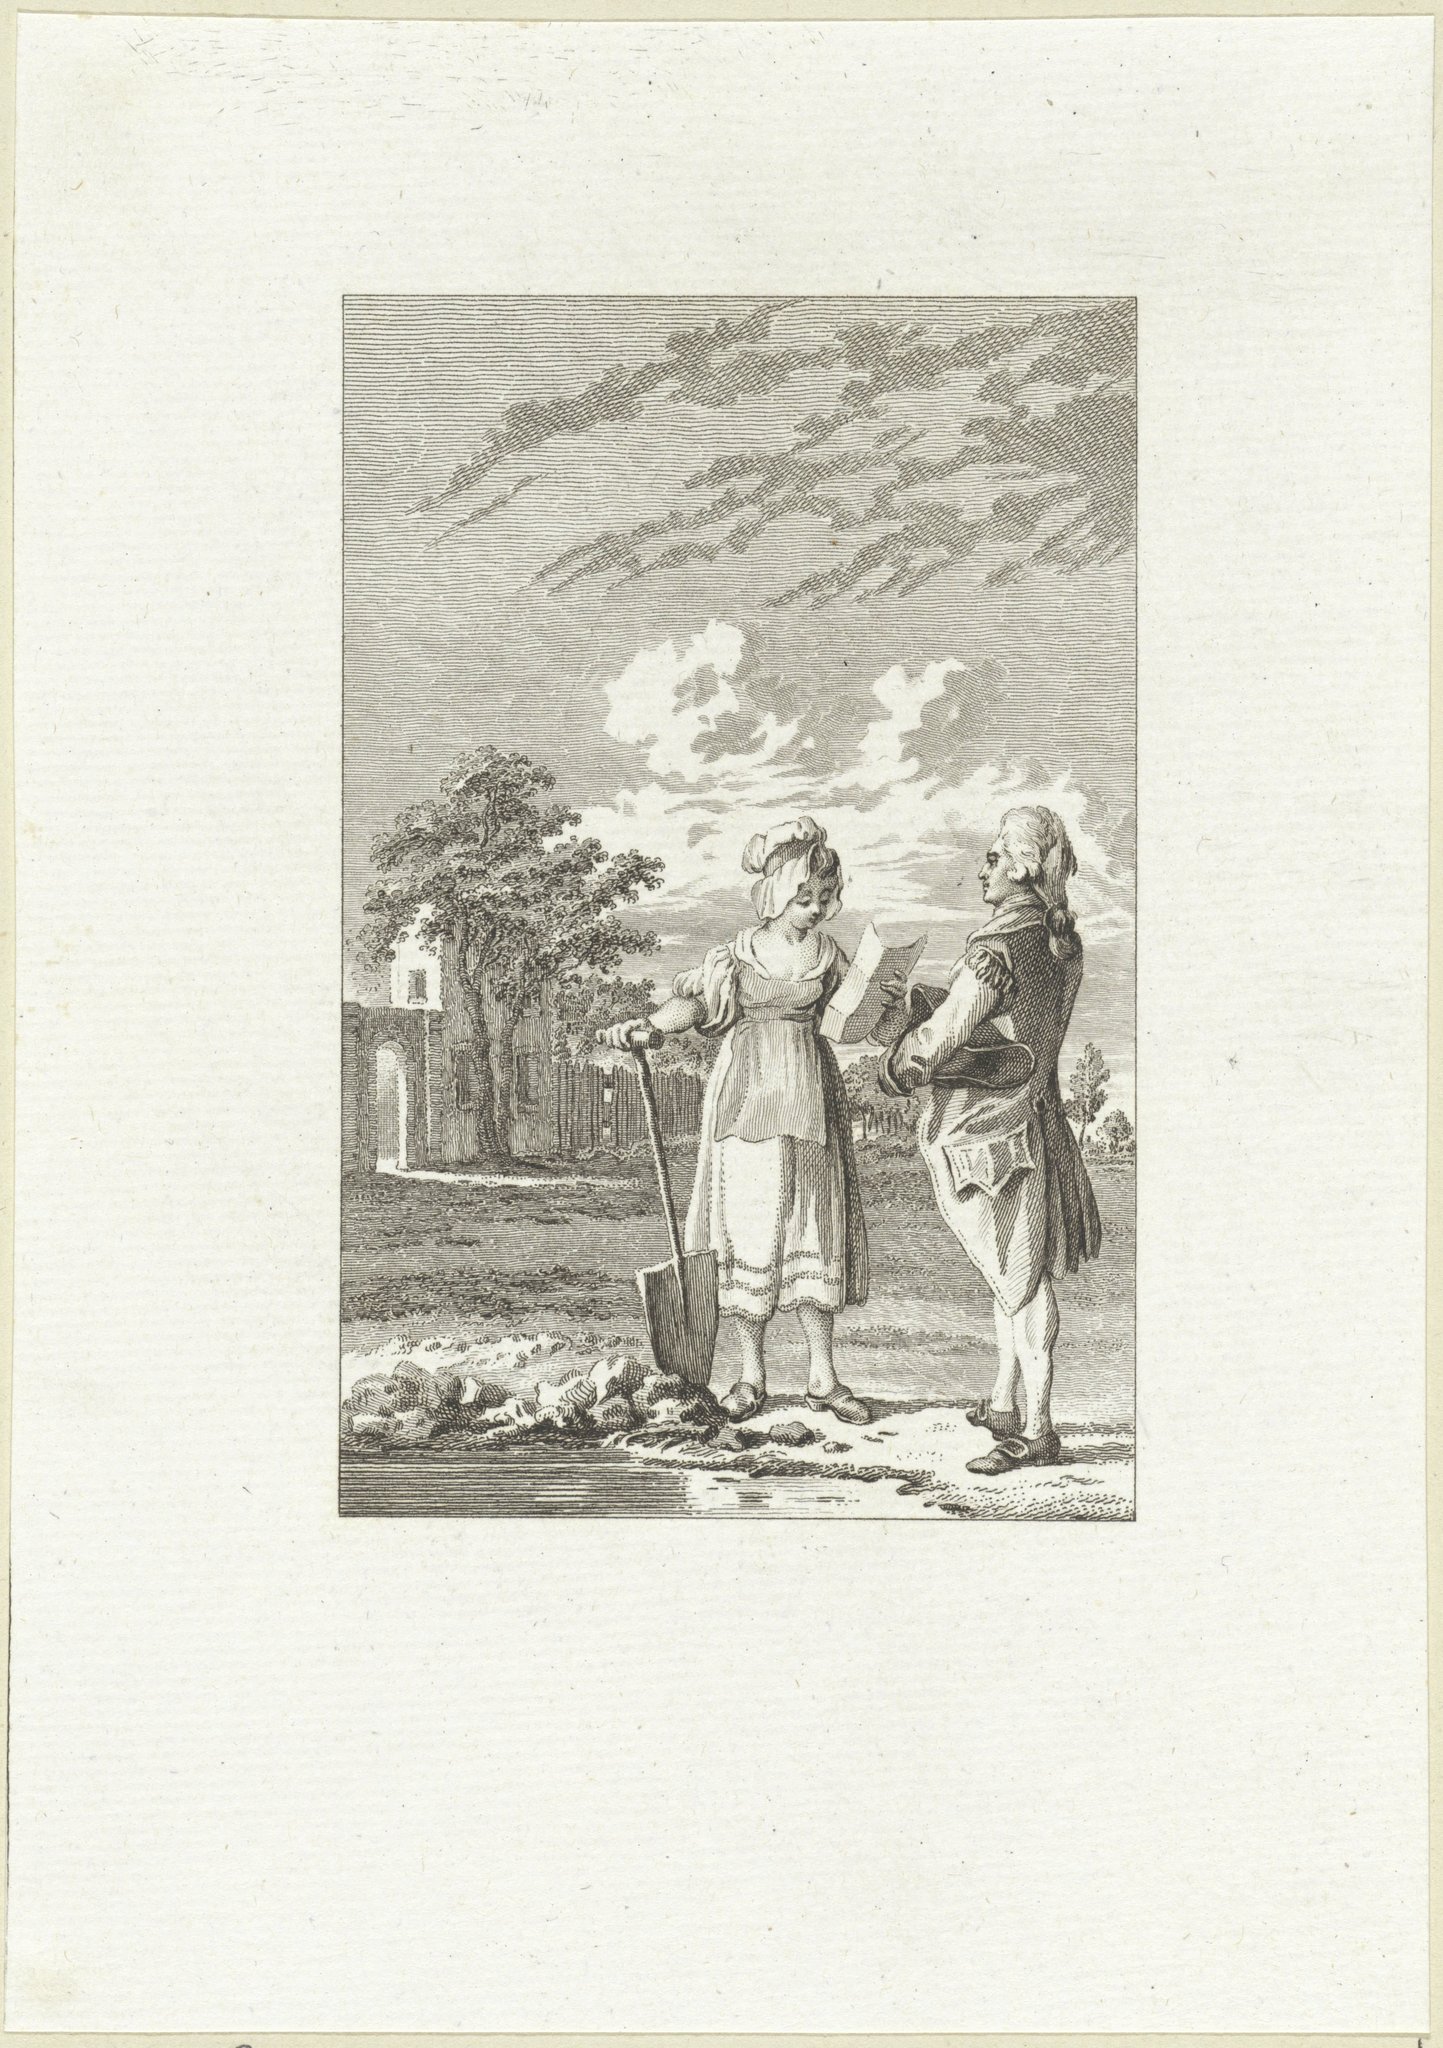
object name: print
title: Vrouw met een schep en een brief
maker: reinier vinkeles (i)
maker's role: draughtsman, print maker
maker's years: 1741-1816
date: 1789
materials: paper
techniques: engraving, etching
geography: amsterdam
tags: reading, landscapes, agricultural implements: spade, letter, envelope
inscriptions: collector's mark: Lugt 240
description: Proefdruk van een prent die ook gebruikt is als illustratie bij het verhaal 'Pauline en Suzette' voor: Baculard d'Arnaud, F.T.M. de. Zedelijke verhaalen, deel 12. Amsterdam: A. Mens Jansz., 1789.